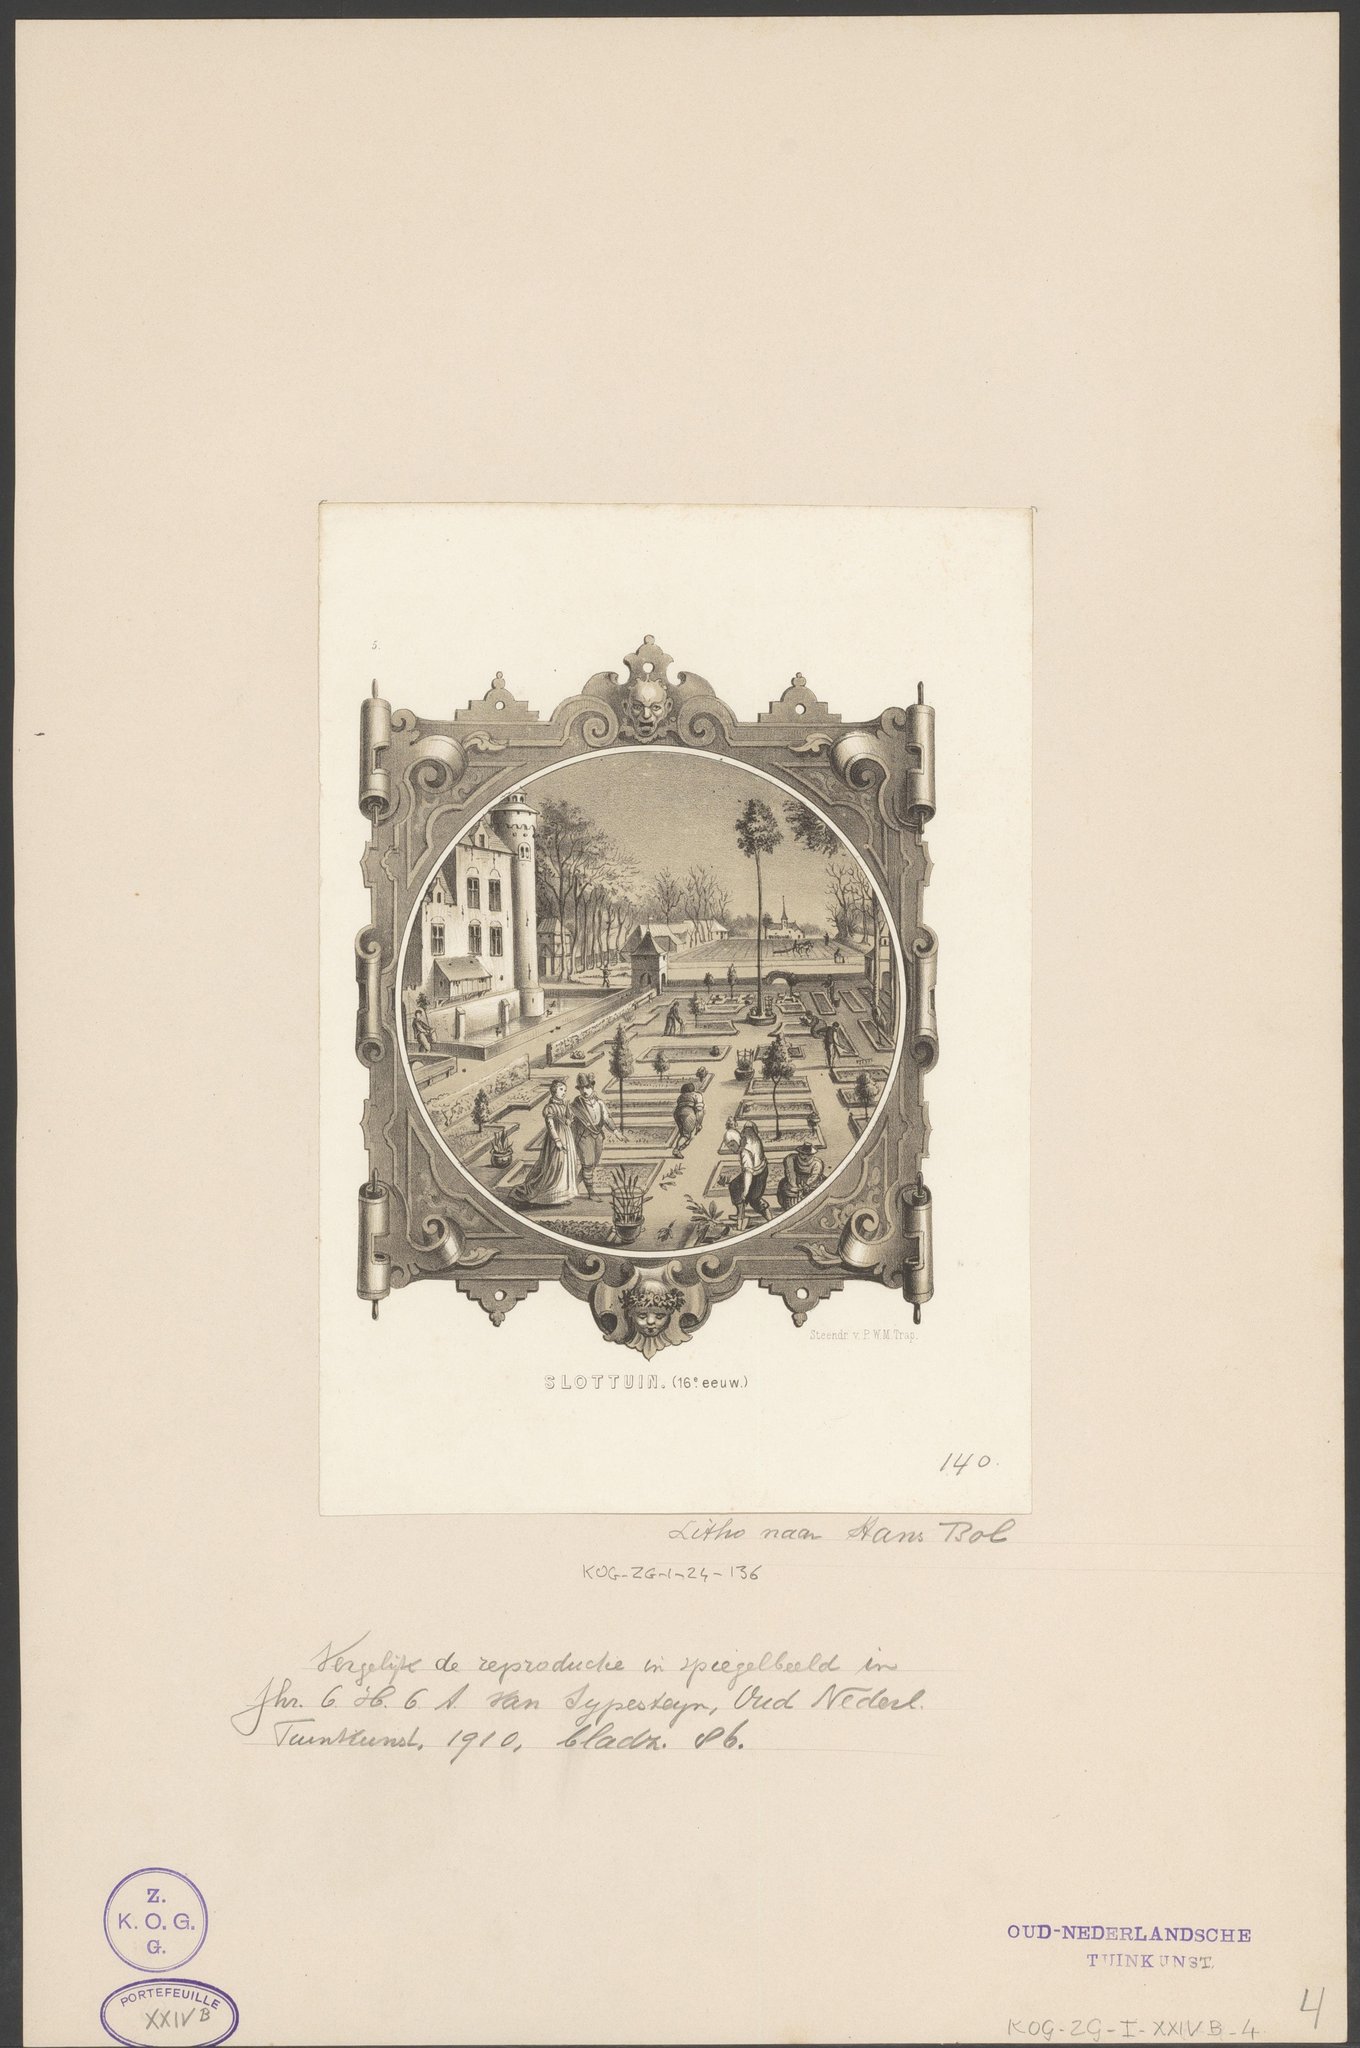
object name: print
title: Slottuin, ca. 1600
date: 1875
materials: paper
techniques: tone lithography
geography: leiden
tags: garden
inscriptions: stamp, collector's mark: Lugt 1641, stamp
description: Slottuin, ca. 1600. Een elegant paar wandelend door een tuin waarin getuinierd wordt. Links een kasteel. Voorstelling in omlijsting met rolwerk. Onderwerpsrubrieken binnen de Atlas Zeden en Gewoonten: Zeden en Gewoonten in Engeren Zin, De Woning, Oude Nederlandsche Tuinkunst. De kasteeltuin.